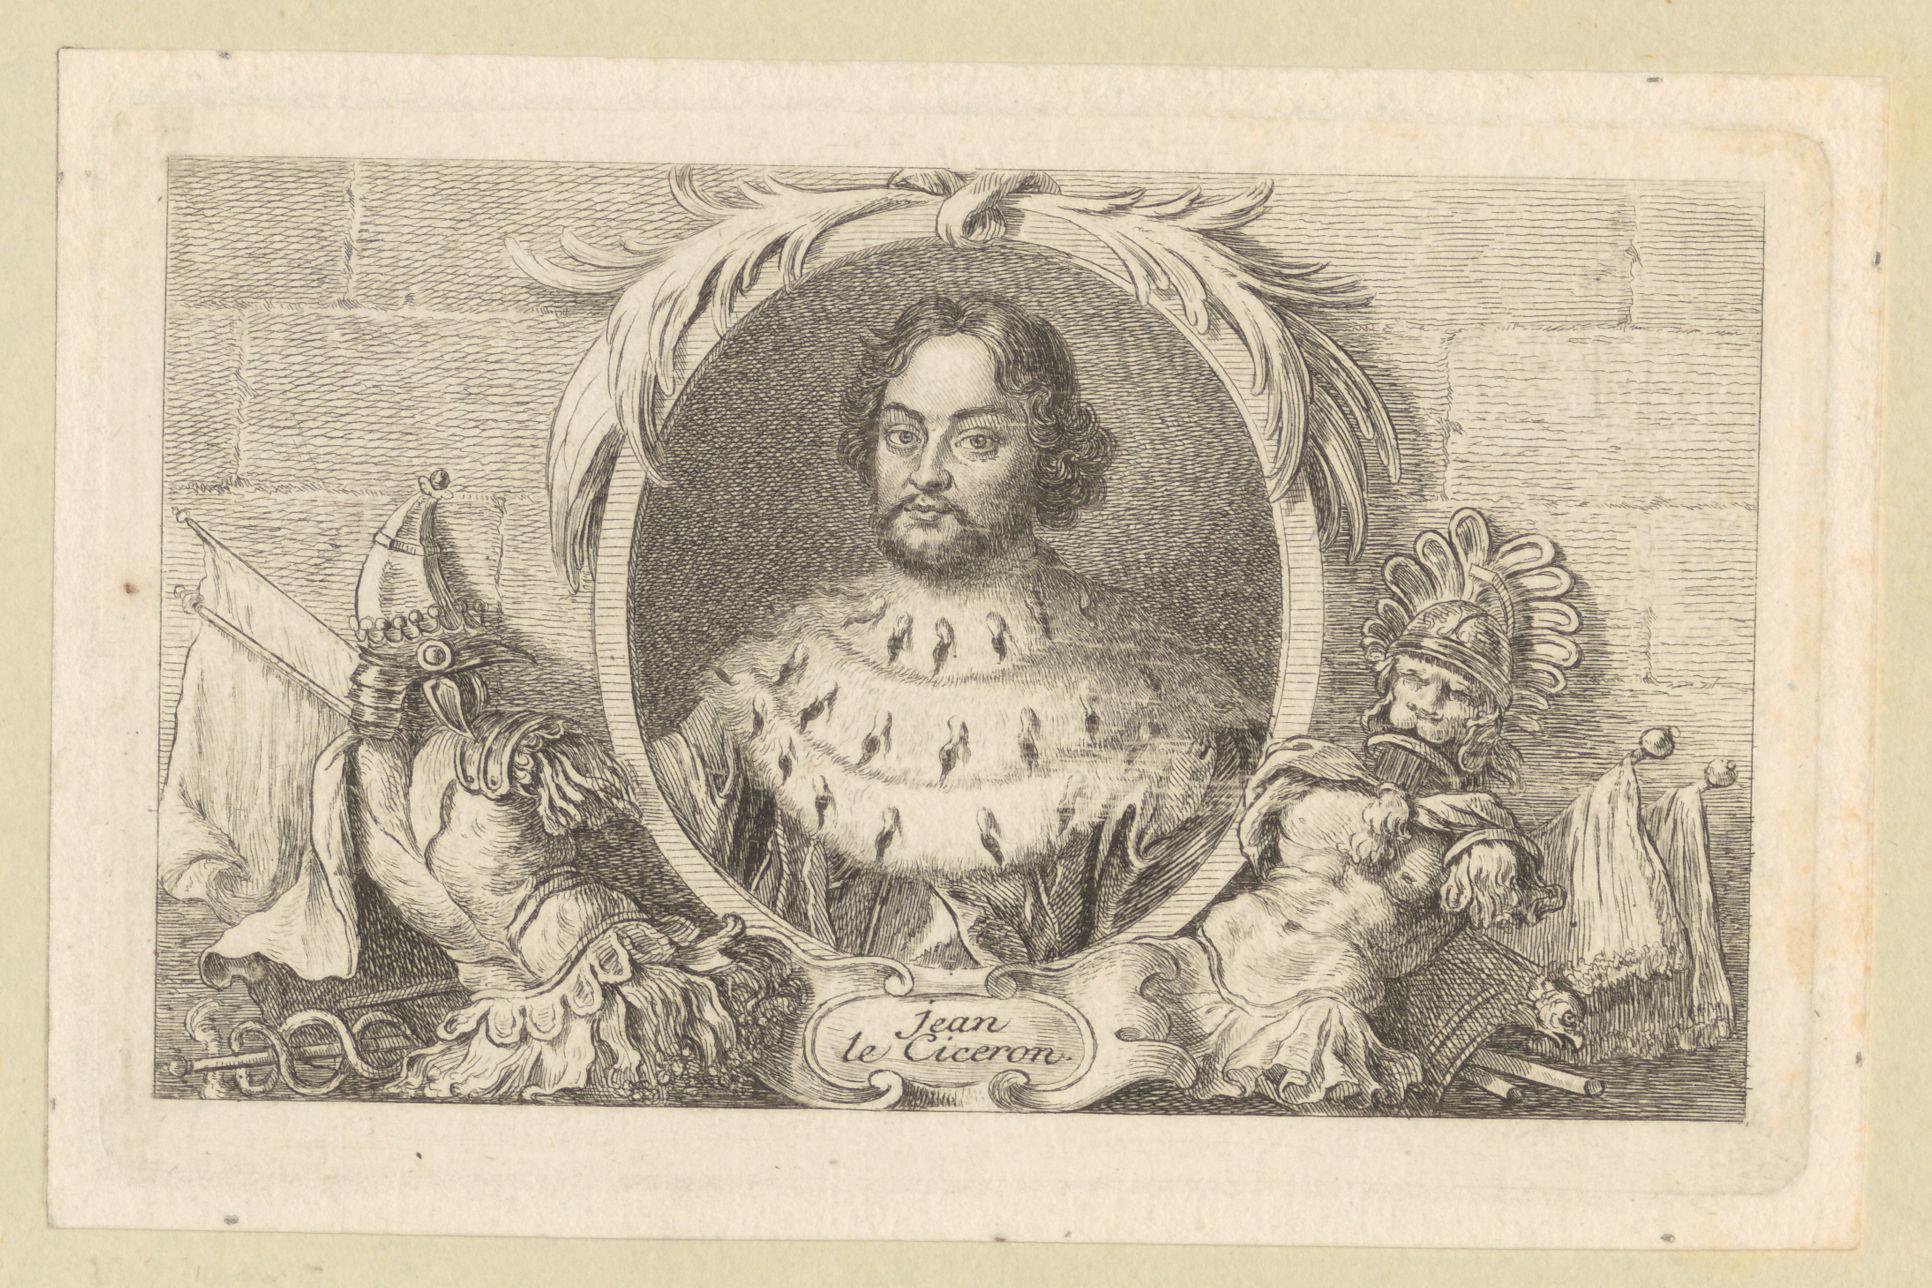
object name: print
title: Portret van Albert III Achilles, keurvorst van Brandenburg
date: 1751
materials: paper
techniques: engraving, etching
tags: historical persons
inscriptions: collector's mark: Lugt 240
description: Prent ook gebruikt in: Frederik de Grote. Mémoires pour servir a l'histoire de la maison de Brandebourg. Sanssouci, Frederik de Grote, 1751.